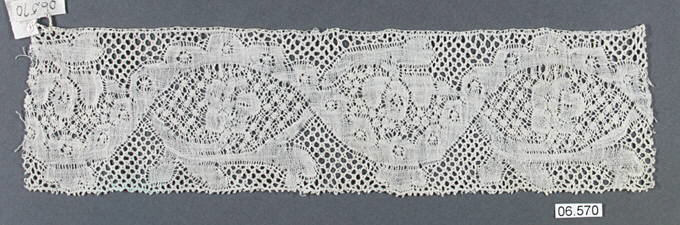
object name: insertion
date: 1701-1800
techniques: lace